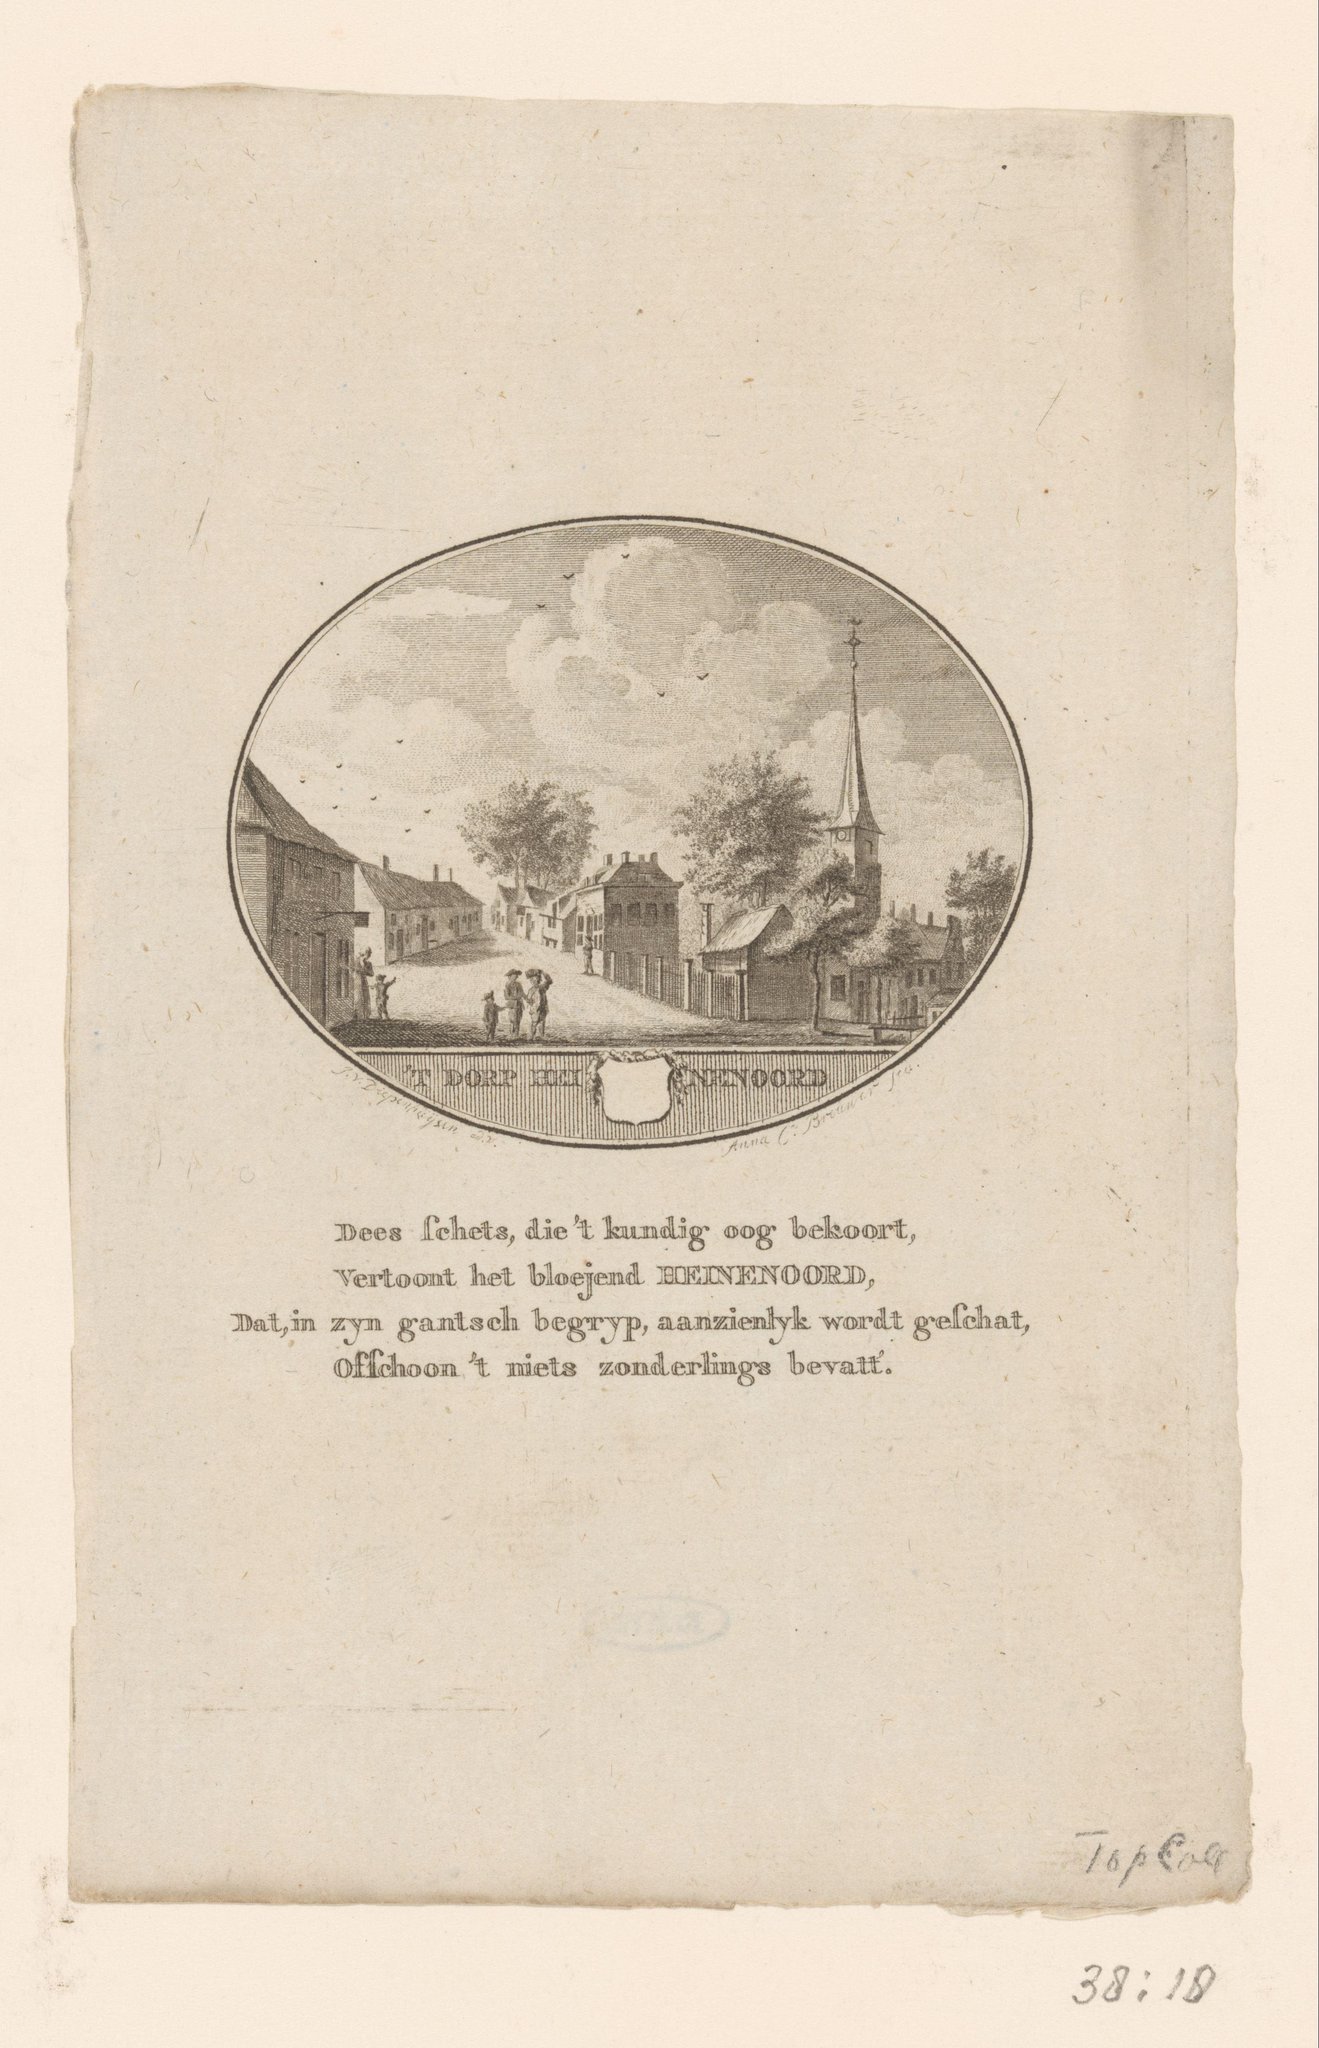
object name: book illustration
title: 't Dorp Heinenoord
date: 1793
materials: paper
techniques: etching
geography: amsterdam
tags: church (exterior), public road in village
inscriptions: collector's mark: Lugt 2228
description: Prent uit: Ollefen, Lieve van. De Nederlandsche stad- en dorp-beschrijver. Amsterdam: Hendrik Arend Banse, 1793, dl. 1.